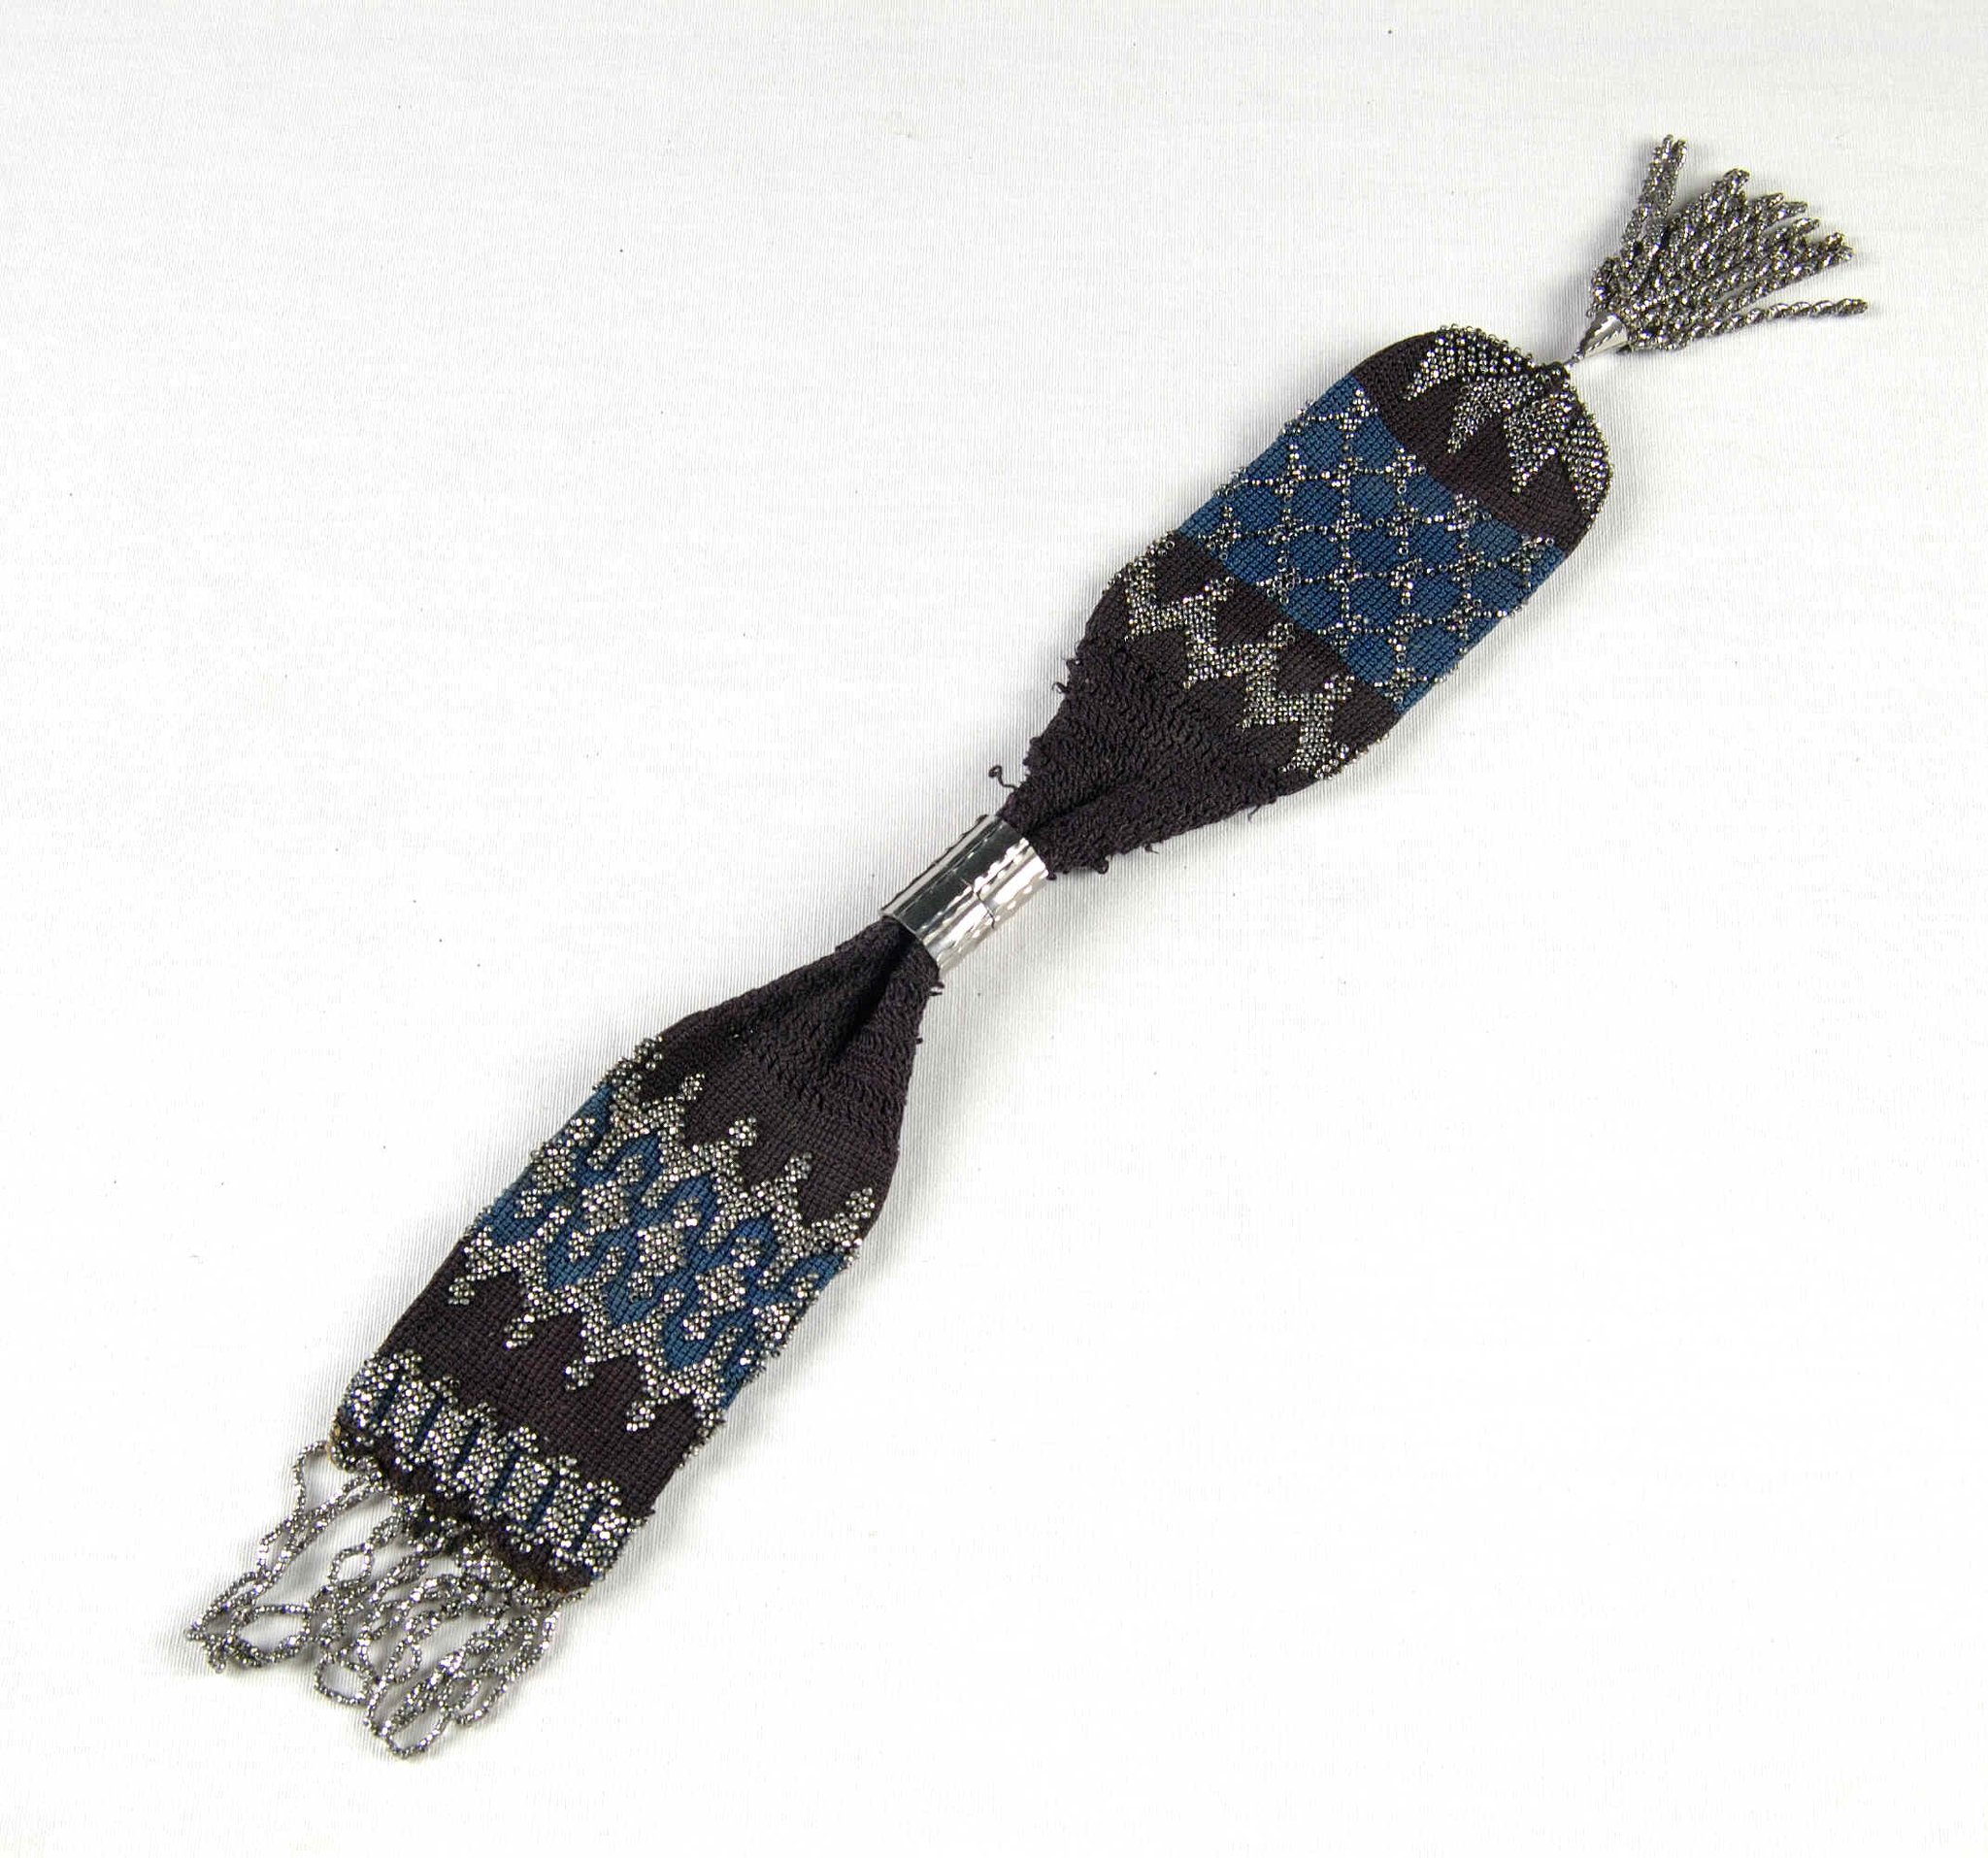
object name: miser's purse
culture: american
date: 1867-1900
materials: cotton, metal